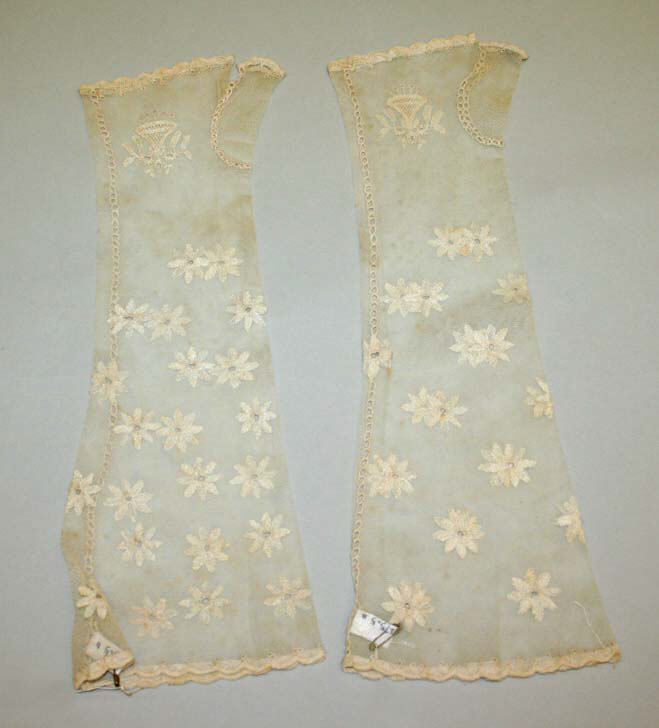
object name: mitt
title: Mitts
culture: british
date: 1767-1800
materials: cotton